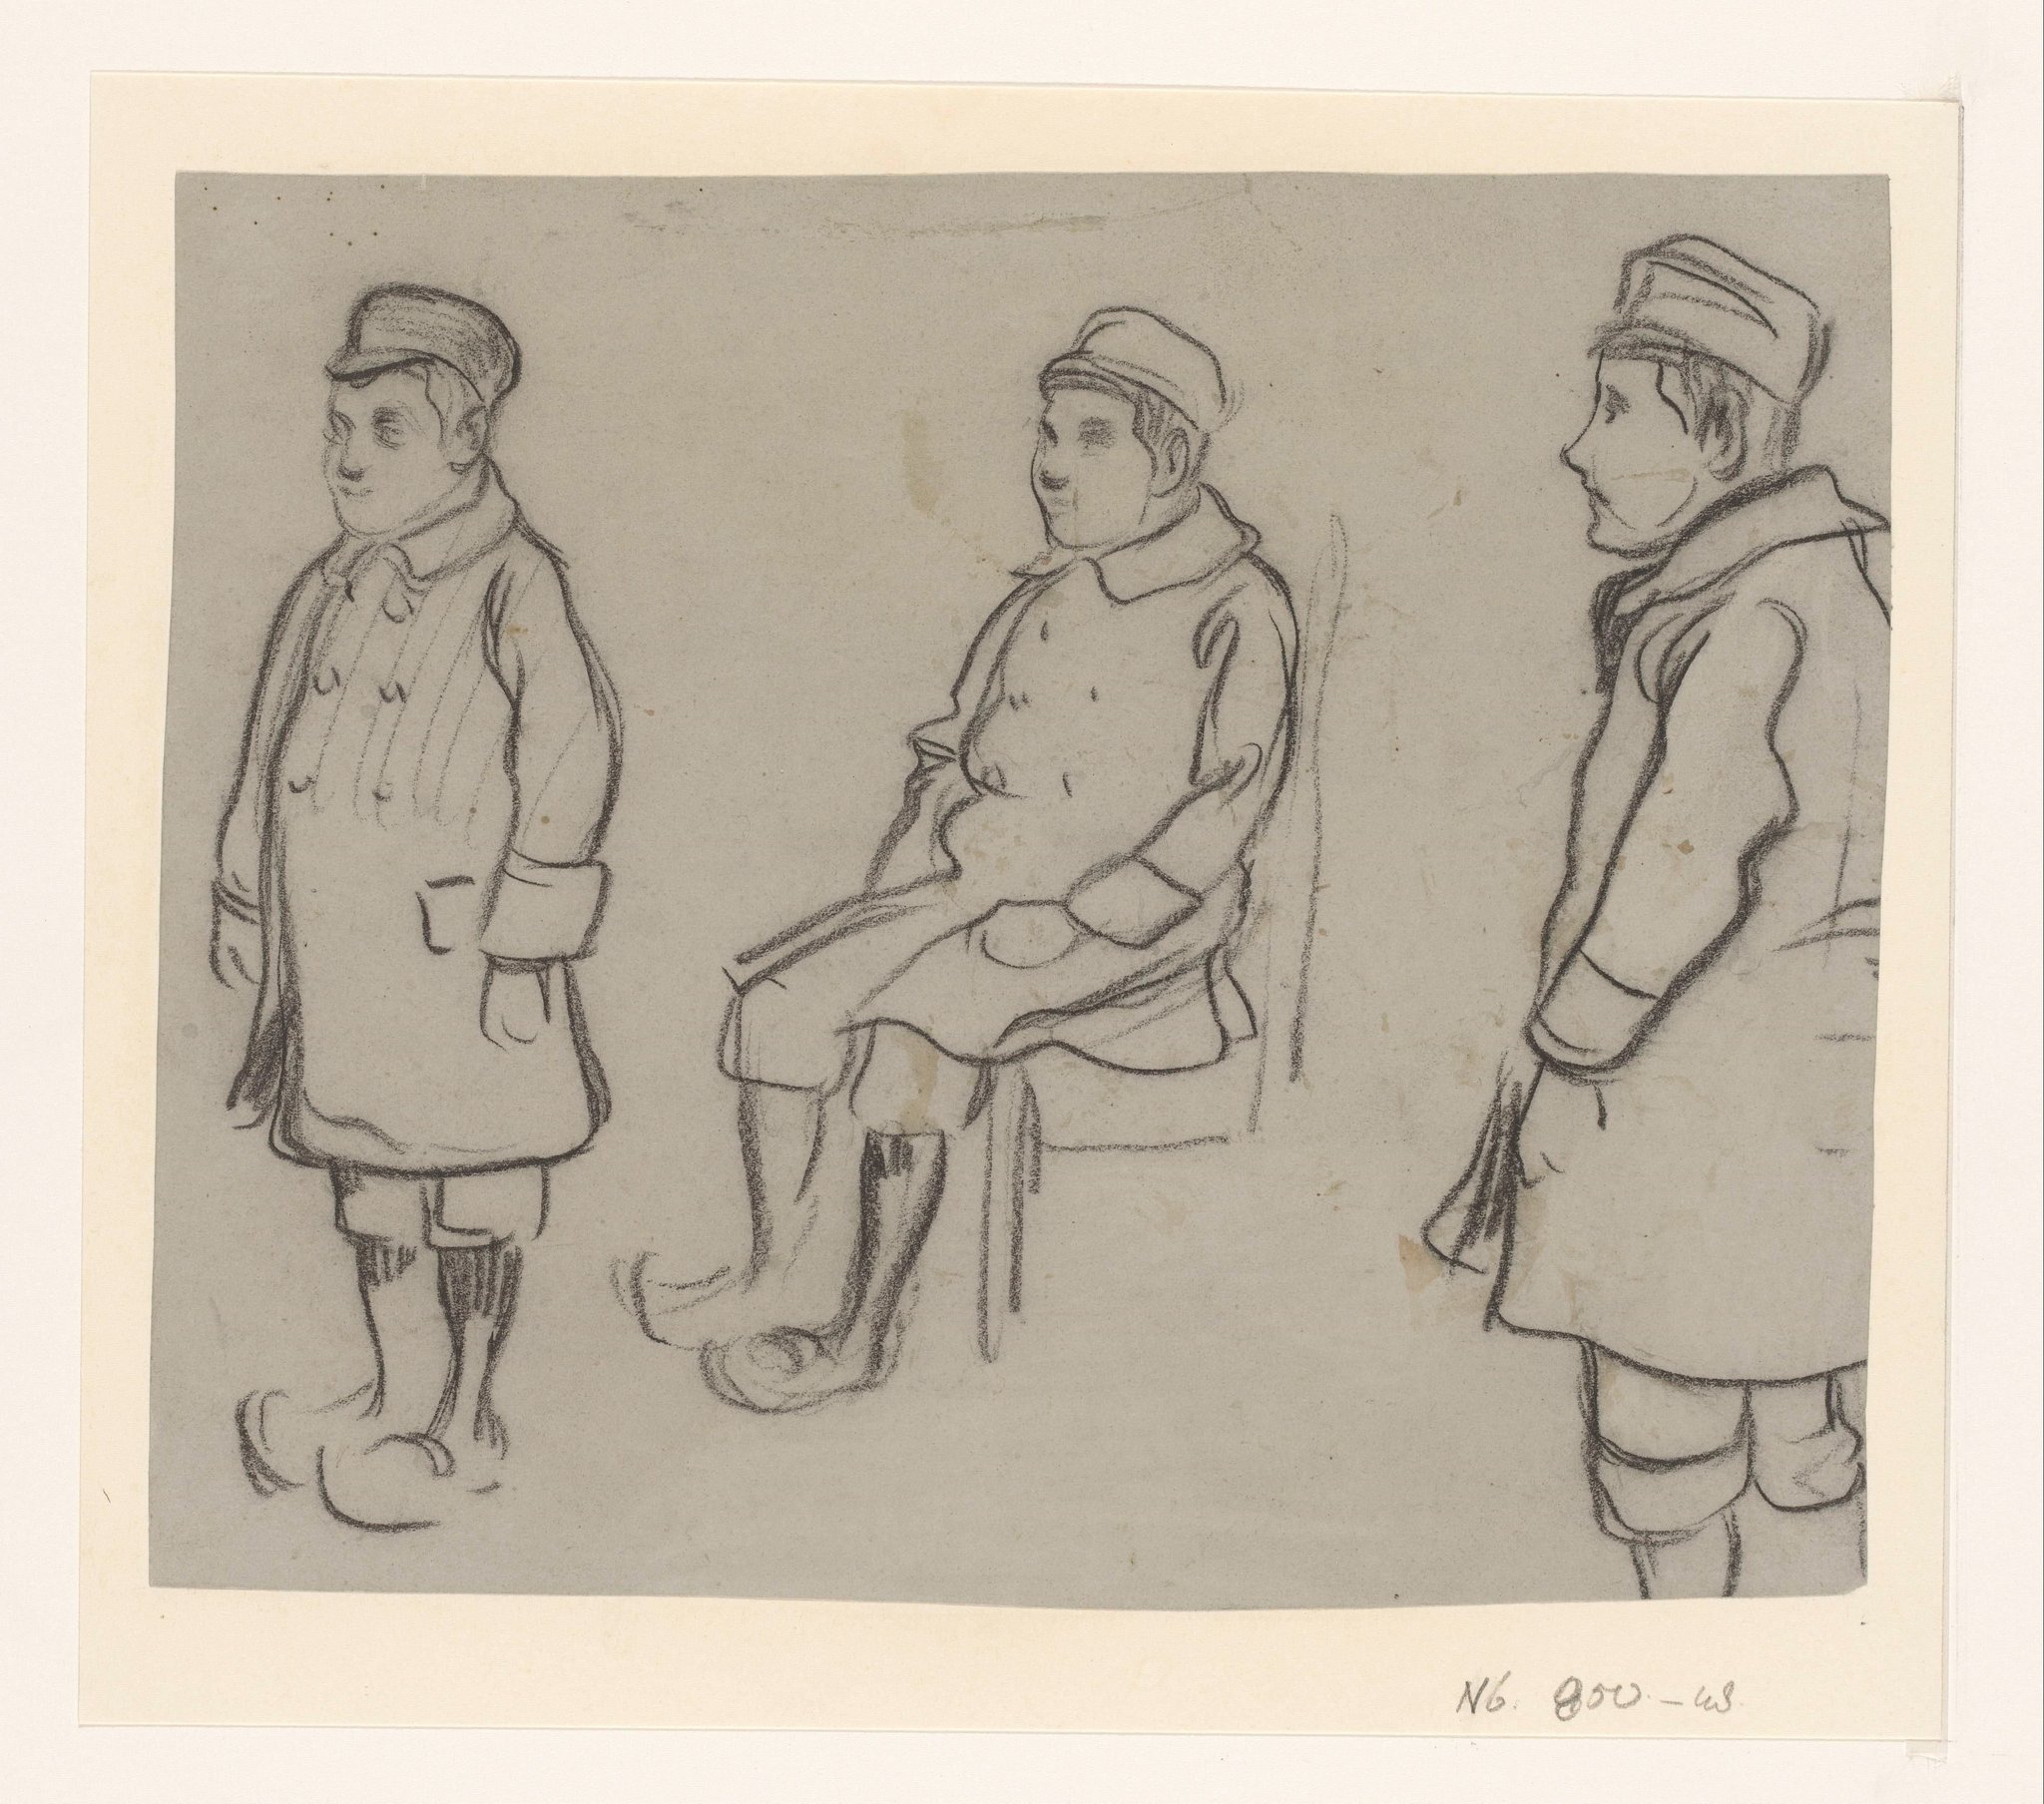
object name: drawing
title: Schetsen van een boerenjongen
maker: jan de waardt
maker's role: draughtsman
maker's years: 1871-1909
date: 1890-1909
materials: chalk, paper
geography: netherlands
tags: farmers, netherlands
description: Schetsblad met drie studies van een boerenjongen met pet, jas en klompen: staande driekwart naar links, zittend op stoel, en profiel naar links.